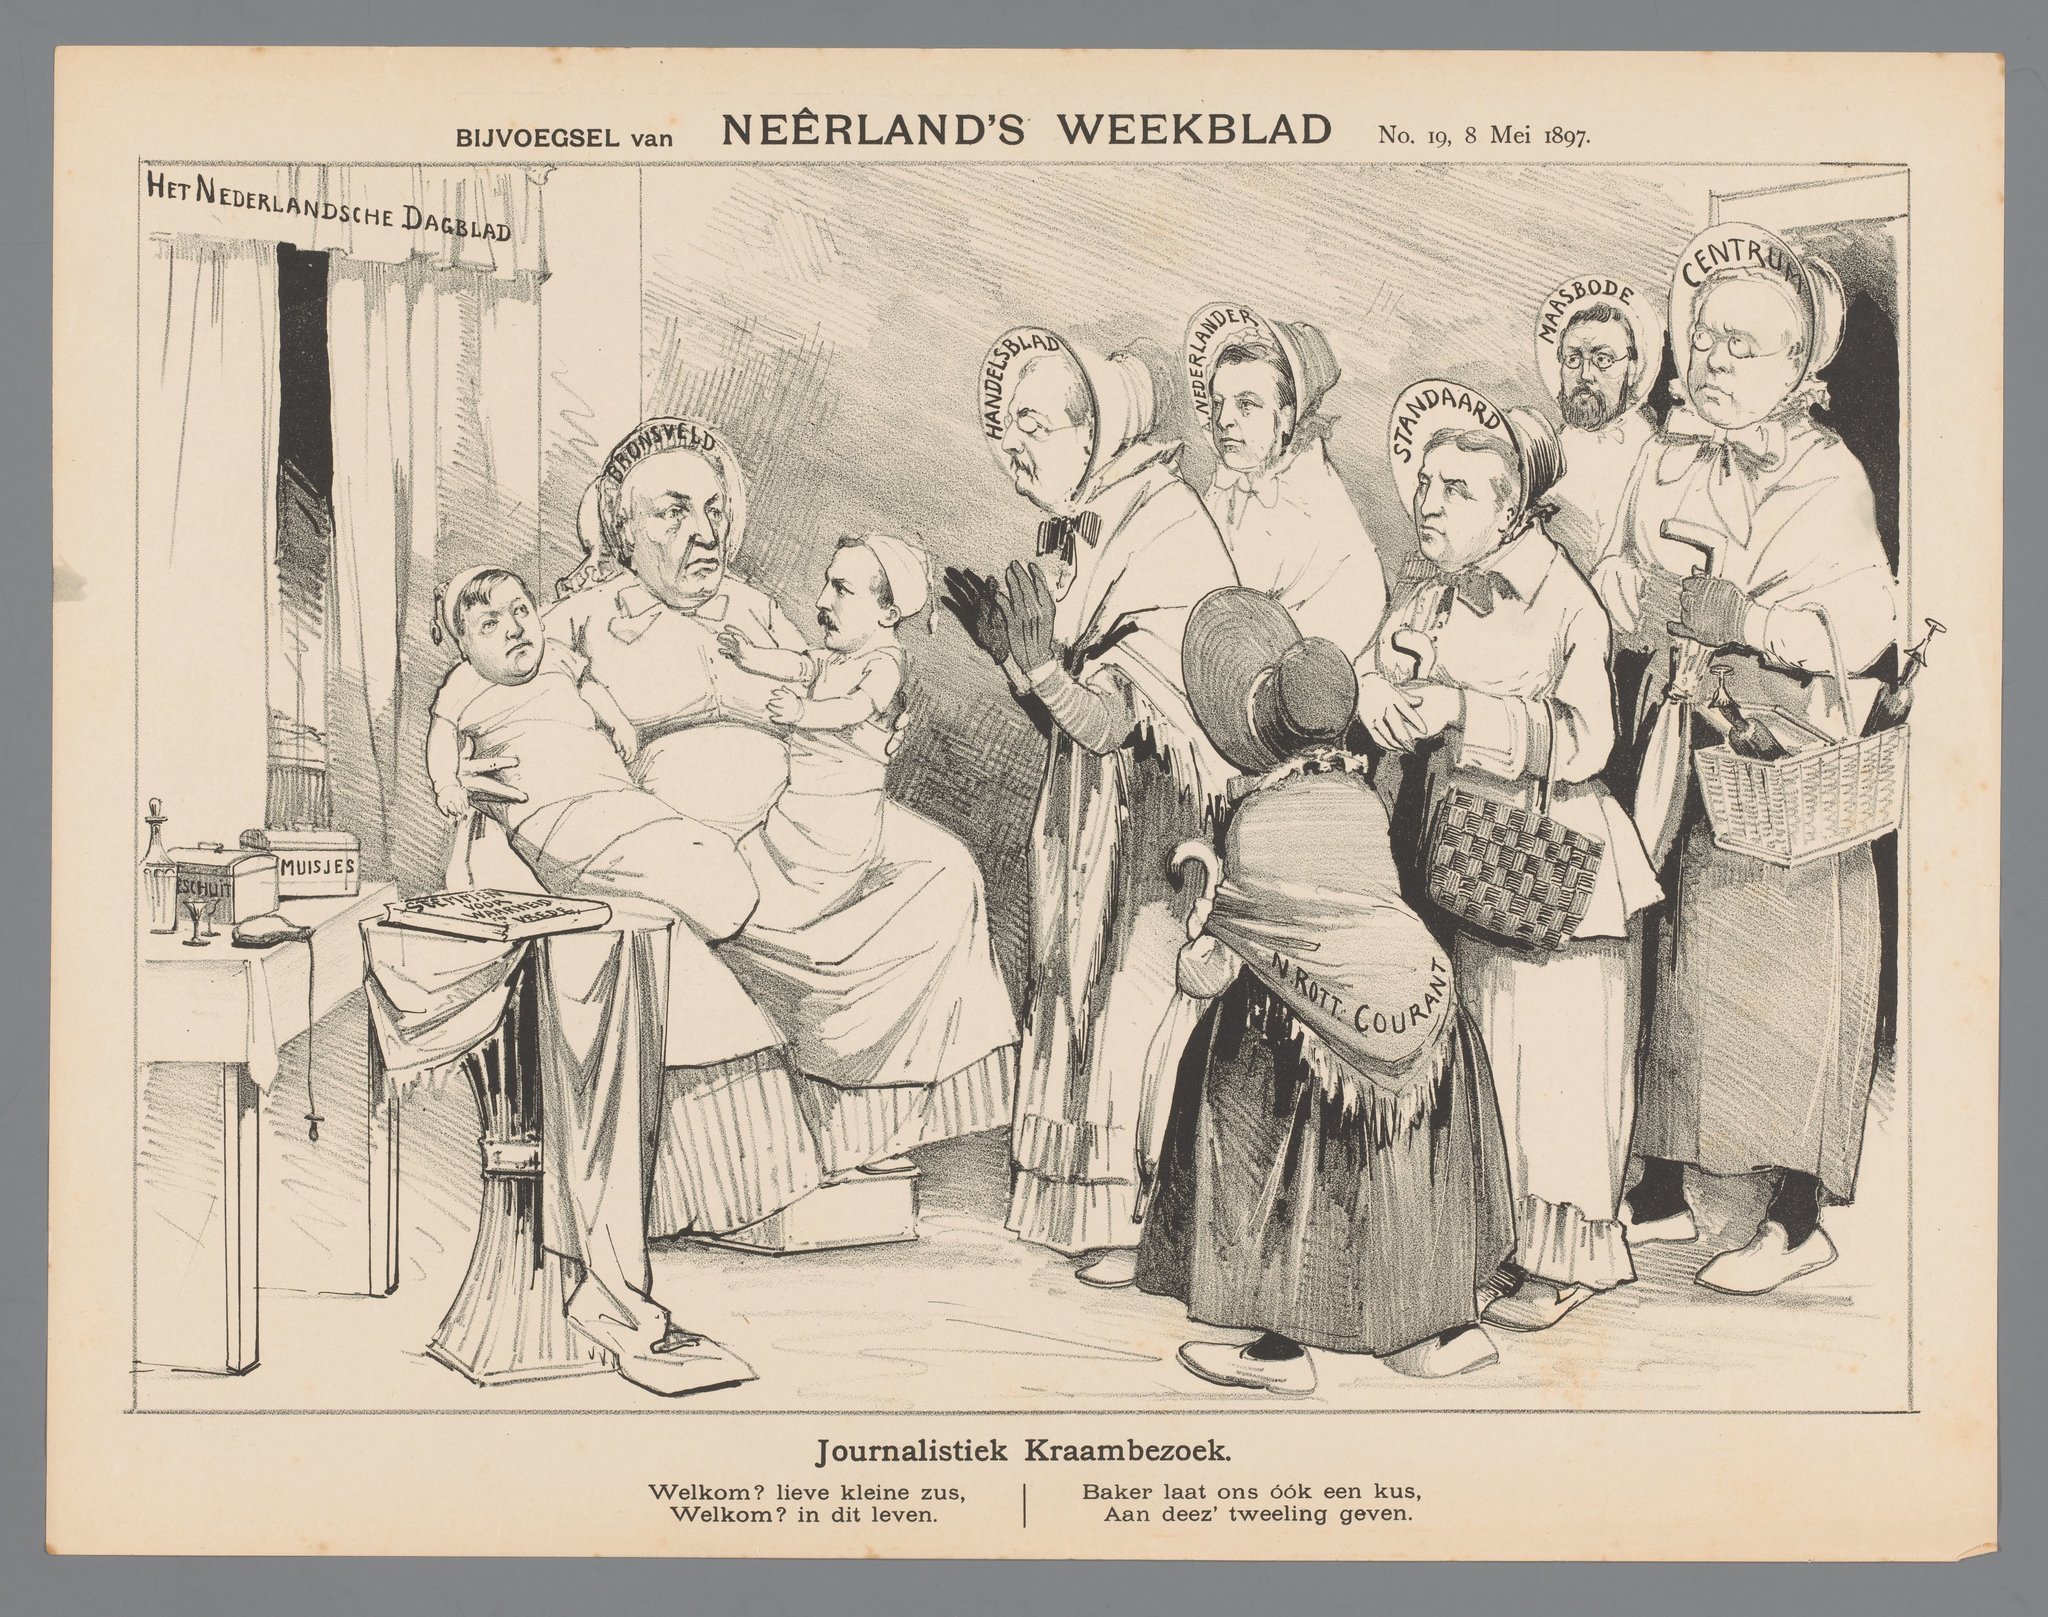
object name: cartoon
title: Journalistiek Kraambezoek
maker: petrus van geldorp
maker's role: draughtsman, print maker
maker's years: 1872-1939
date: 1897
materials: paper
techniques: lithograph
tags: utrecht, historical persons, visiting the new mother, lying-in visit, political caricatures and satires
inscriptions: date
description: Prent uit het bijvoegsel van: Neêrland’s Weekblad, nr. 19, 8 mei 1897.